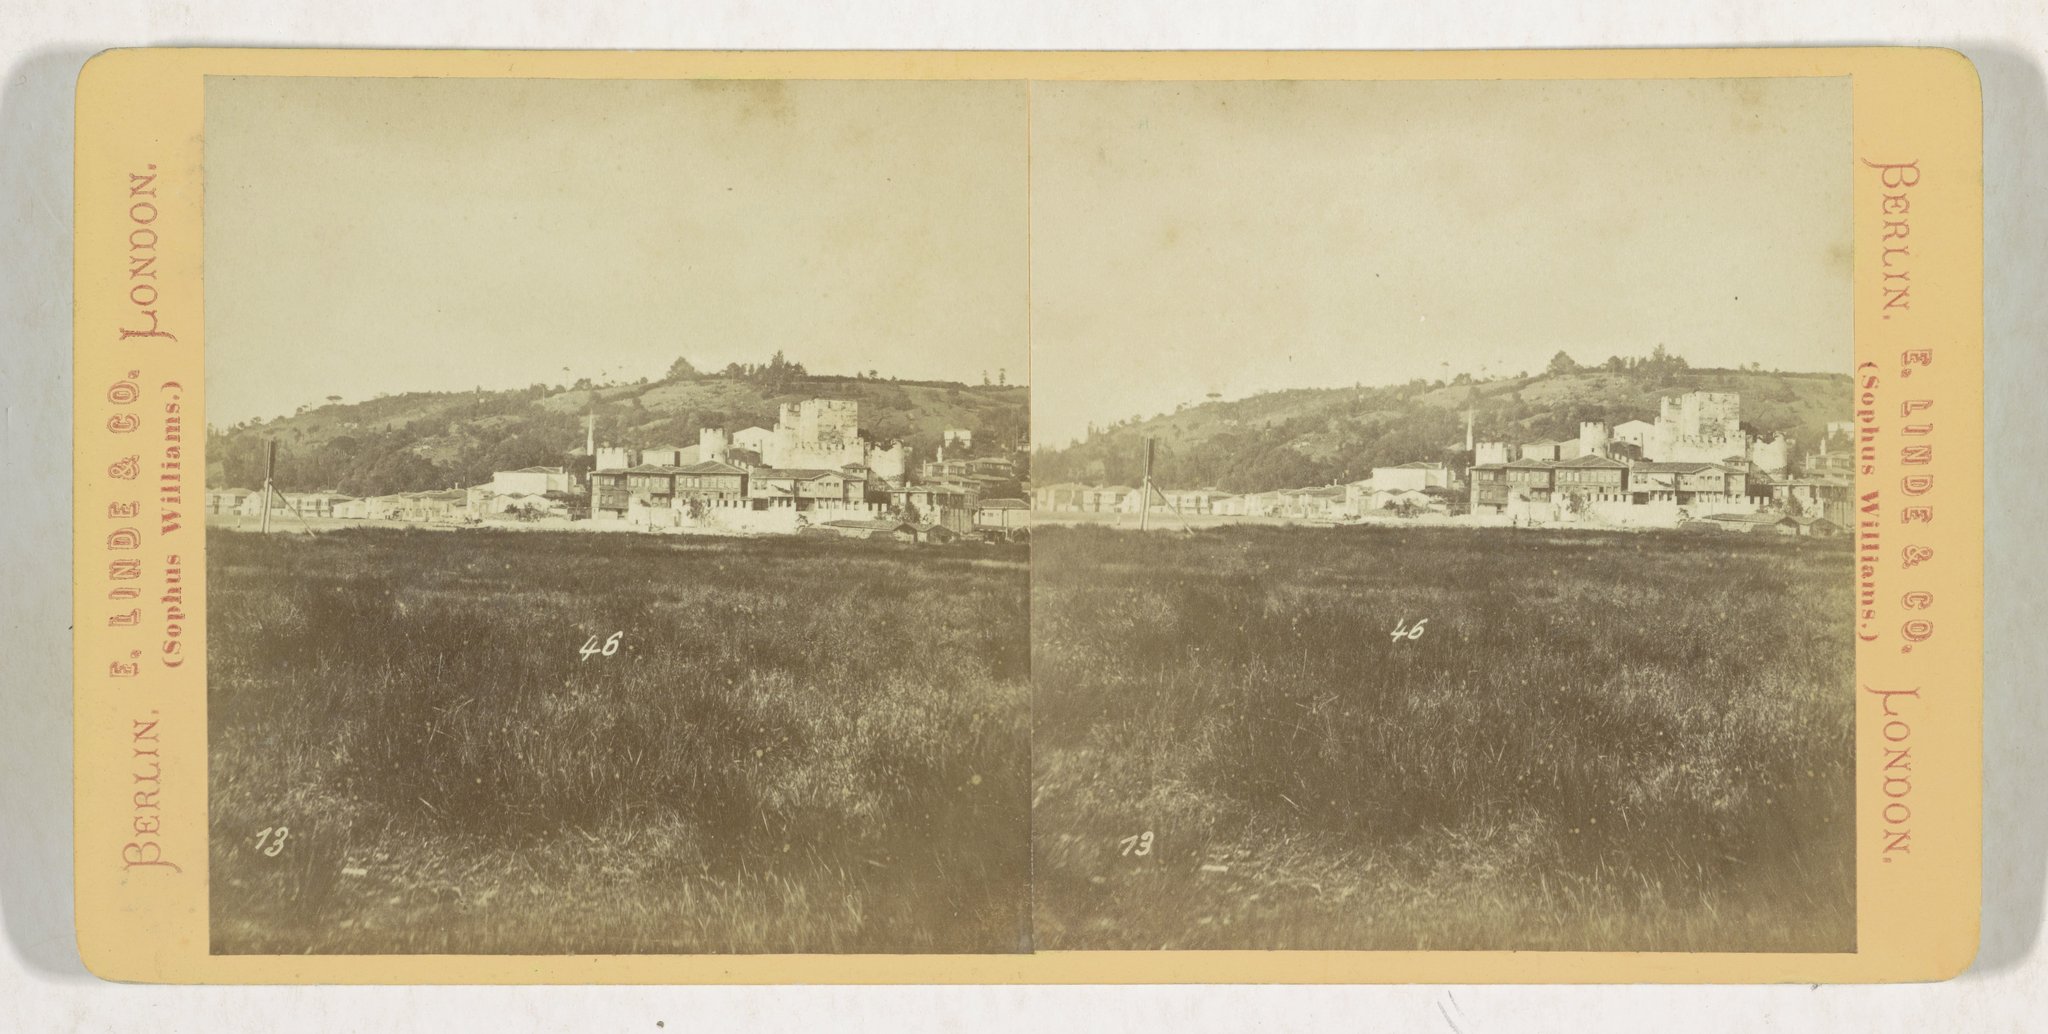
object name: stereograph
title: Constantinopel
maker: Anonymous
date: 1873-1890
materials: cardboard, paper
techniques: albumen print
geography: berlin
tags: castle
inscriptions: number: ‘46’, number: ‘13’